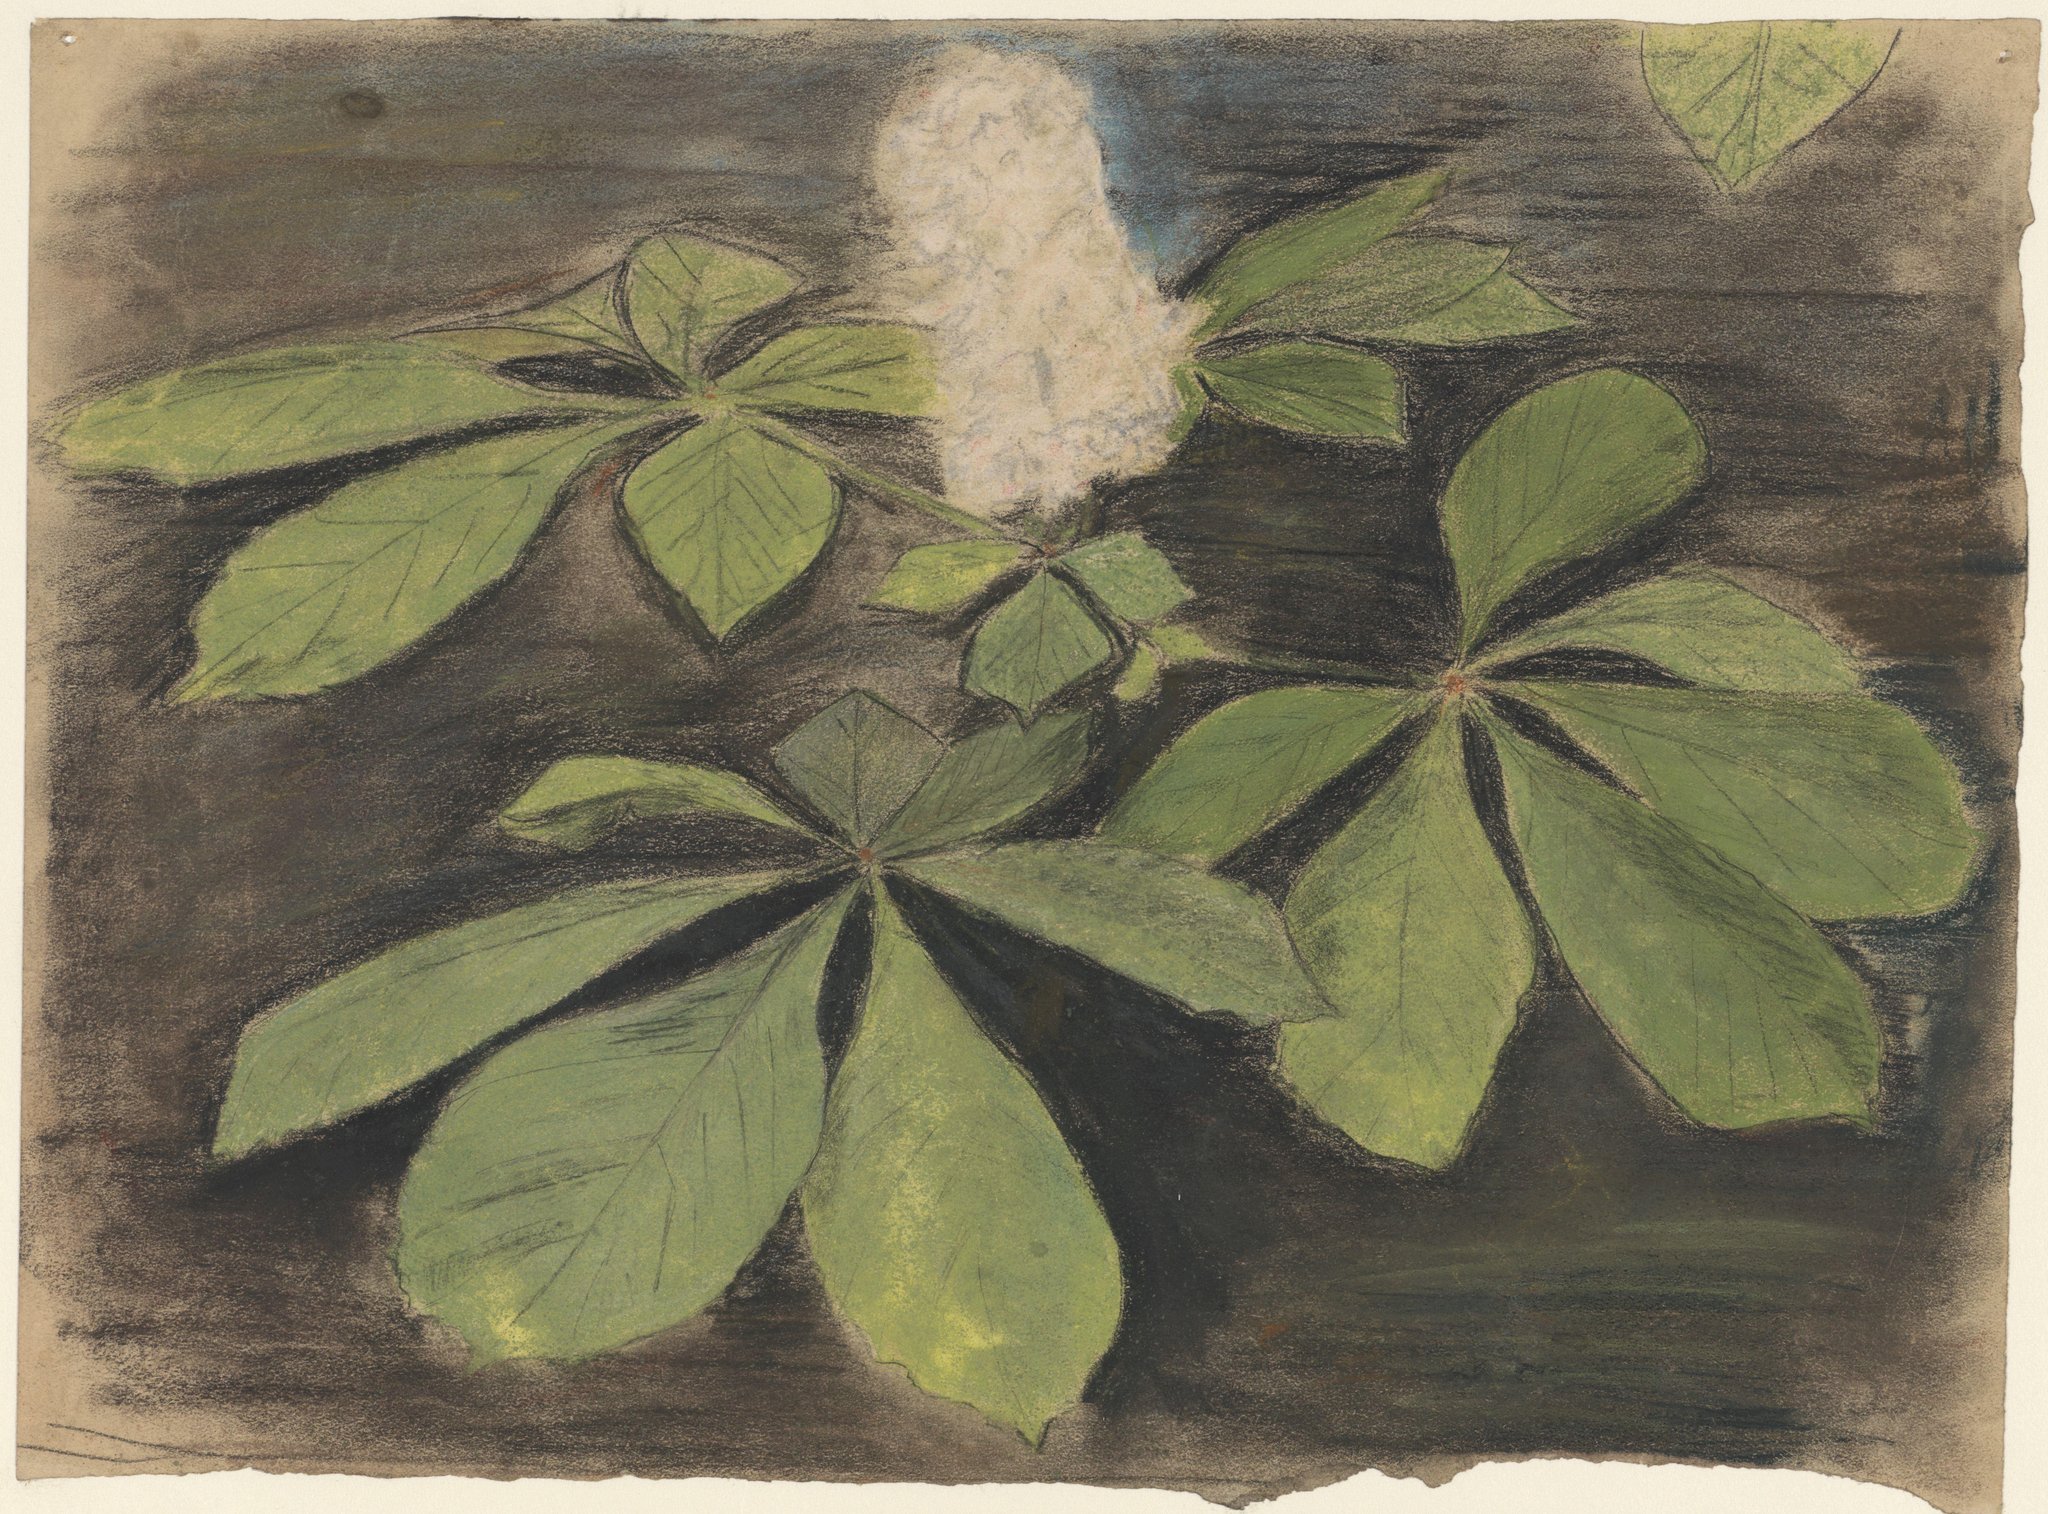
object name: drawing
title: Kastanjebladeren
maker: theo nieuwenhuis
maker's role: designer, draughtsman, print maker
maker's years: 1866-1951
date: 1876-1951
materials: chalk, paper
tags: trees: horse chestnut (leaves, putting forth leaves)